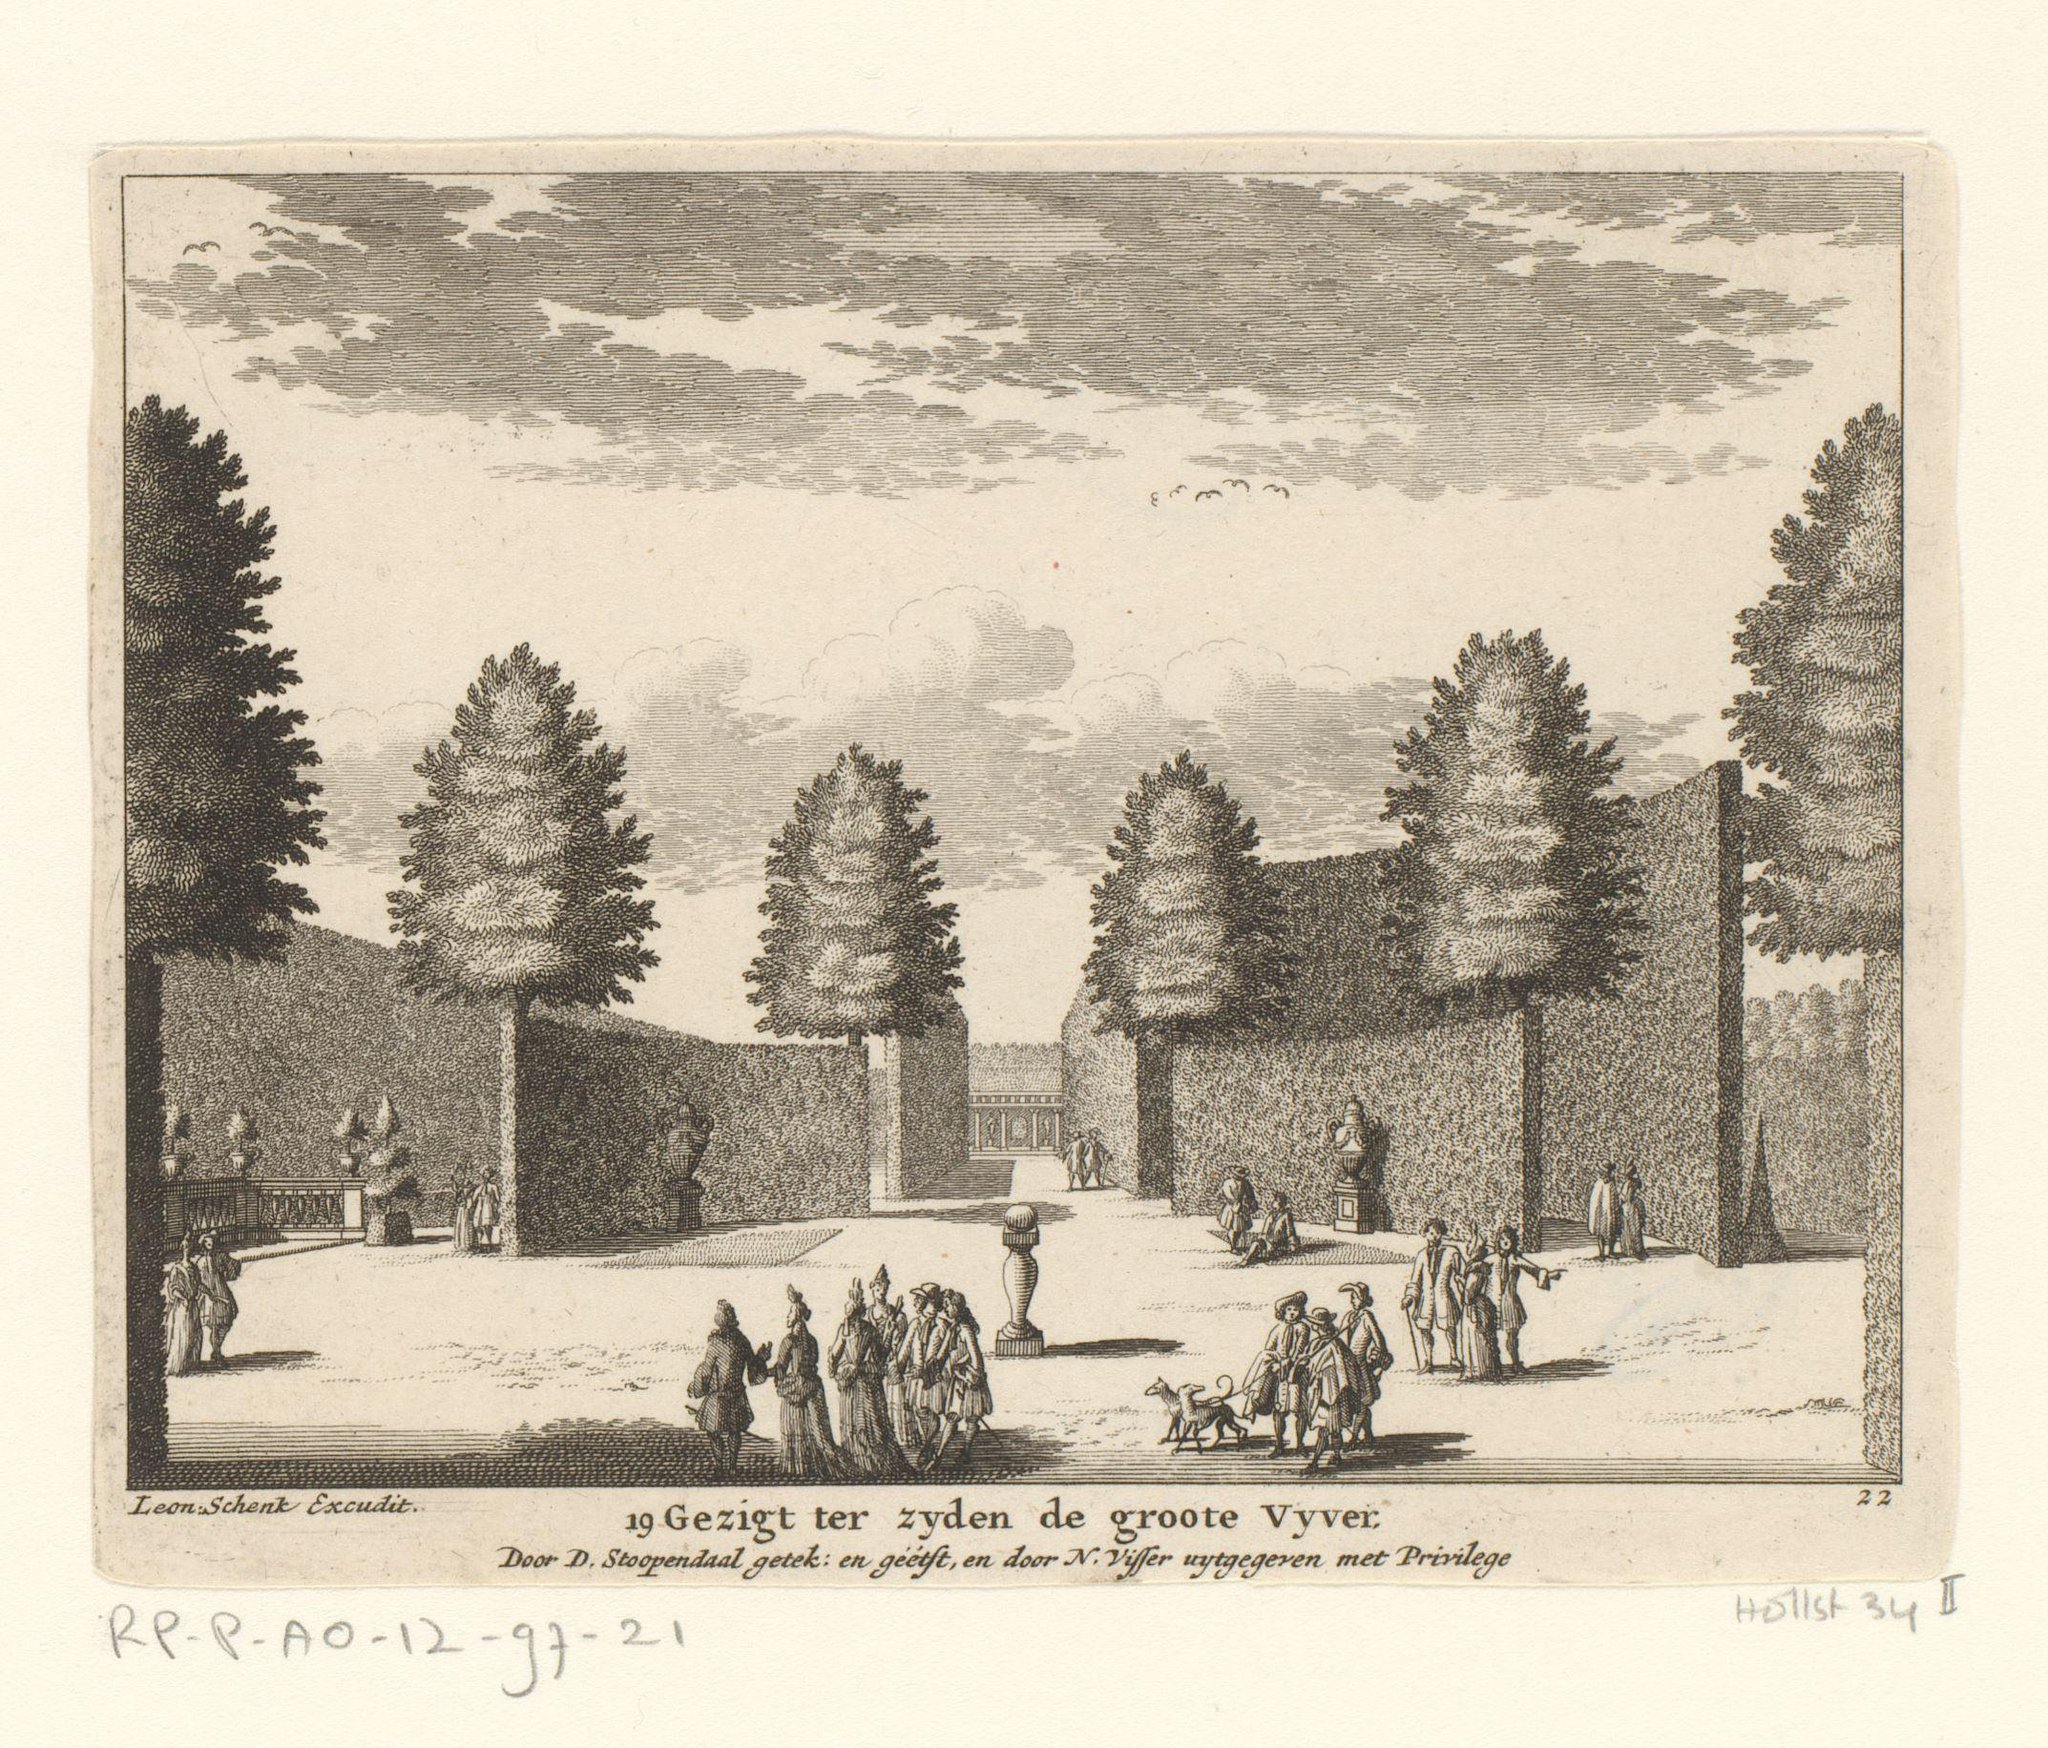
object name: print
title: Gezigt ter zyden de groote Vyver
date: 1682-1726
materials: paper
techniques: etching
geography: amsterdam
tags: french or architectonic garden; formal garden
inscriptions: collector's mark: Lugt 2228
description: Gezicht op de tuinen bij Huis Clingendael te Den Haag. Op een plein omgeven door hagen wandelen figuren. Links de steiger met balustrade bij de grote vijver.